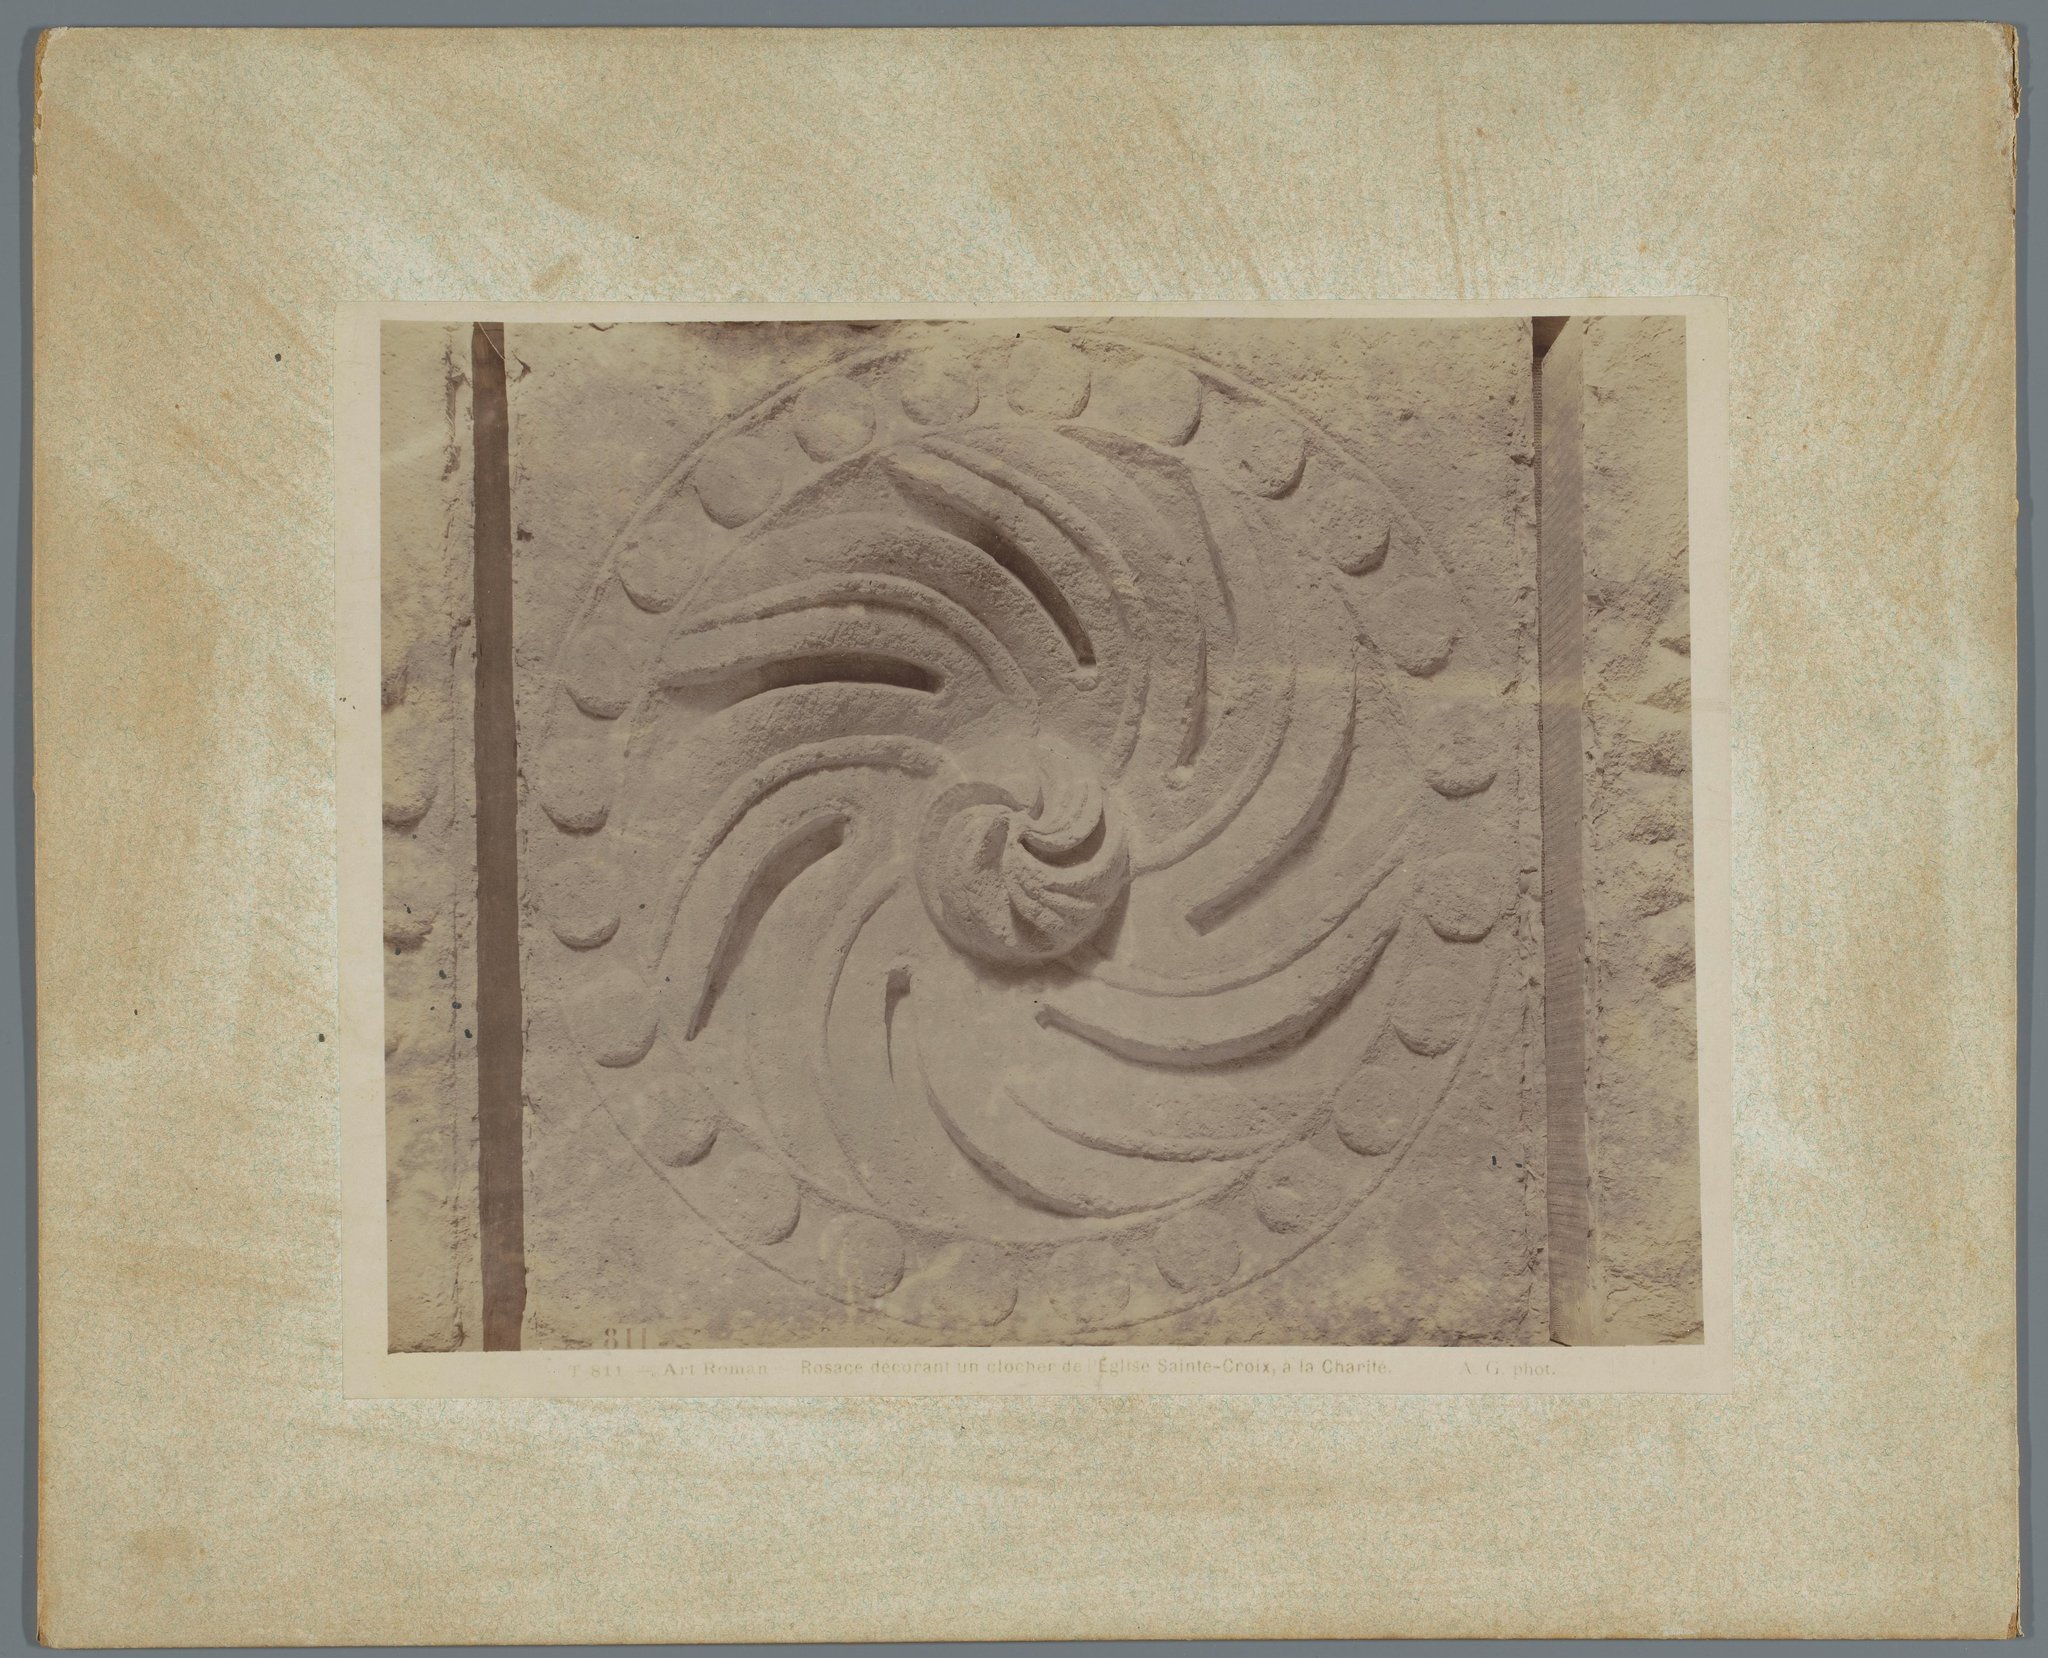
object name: photograph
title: Art Roman - Rosace décorant un clocher de l 'Église Sainte-Croix, à la Charité.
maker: adolphe giraudon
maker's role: publisher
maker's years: 1849-1929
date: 1875-1900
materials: cardboard, photographic support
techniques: albumen print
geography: france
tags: ornament ~ round and curved forms, sculpture (+ relief ~ sculpture)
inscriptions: number: ‘T 811’, collector's mark: ‘RIJKS-NORMAALSCHOOL voor TEEKENONDERWIJZERS AMSTERDAM’